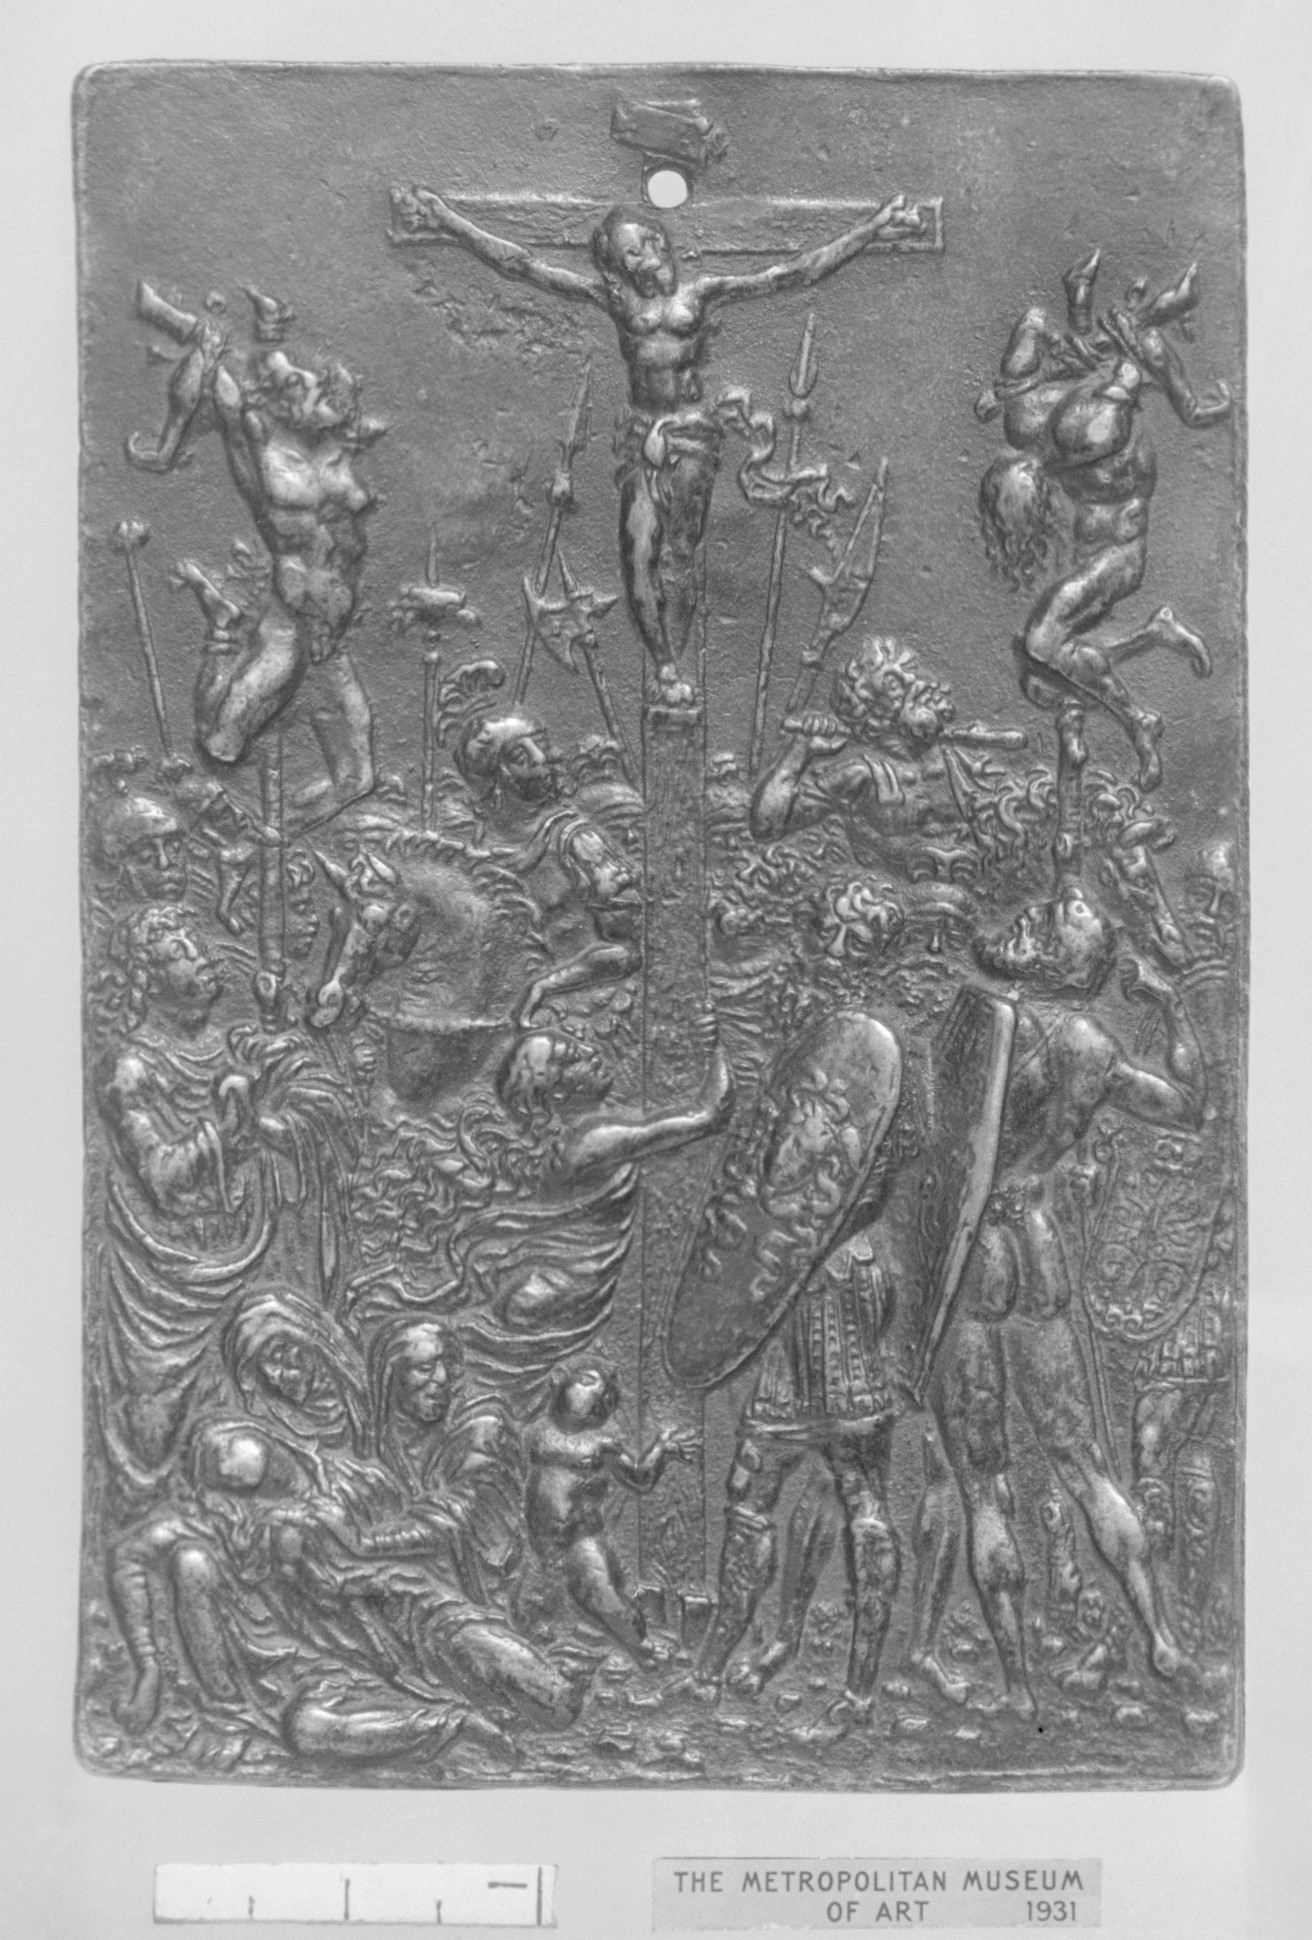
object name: plaquette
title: The Crucifixion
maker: moderno (galeazzo mondella)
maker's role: artist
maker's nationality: italian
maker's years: 1467-1528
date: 1501-1600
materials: bronze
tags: sadness,male nudes,christ,saint john the evangelist,virgin mary,crucifixion